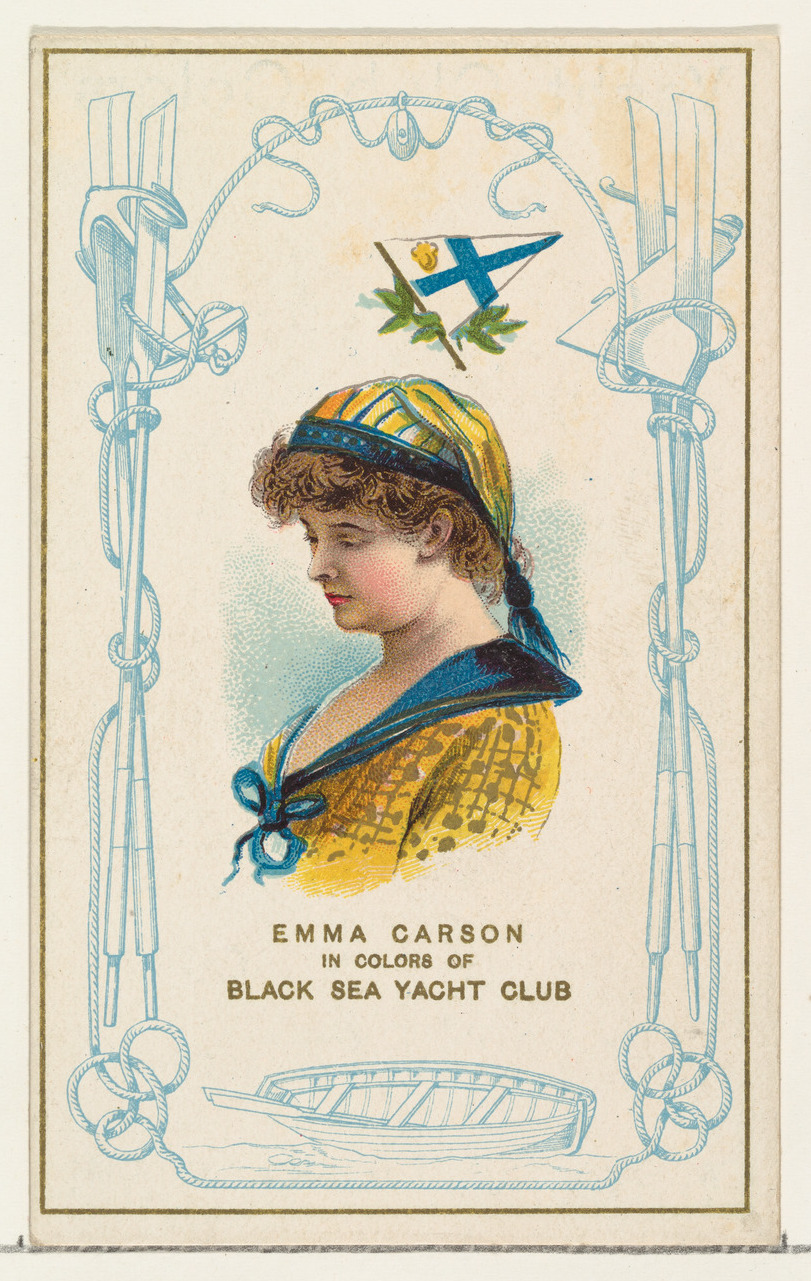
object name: print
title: Emma Carson in Colors of Black Sea Yacht Club, from the Yacht Colors of the World series (N140) issued by Duke Sons & Co. to promote Honest Long Cut Tobacco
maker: w. duke, sons & co.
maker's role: publisher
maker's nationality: american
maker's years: 1870-1920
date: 1890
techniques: color lithograph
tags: profiles,women,flags